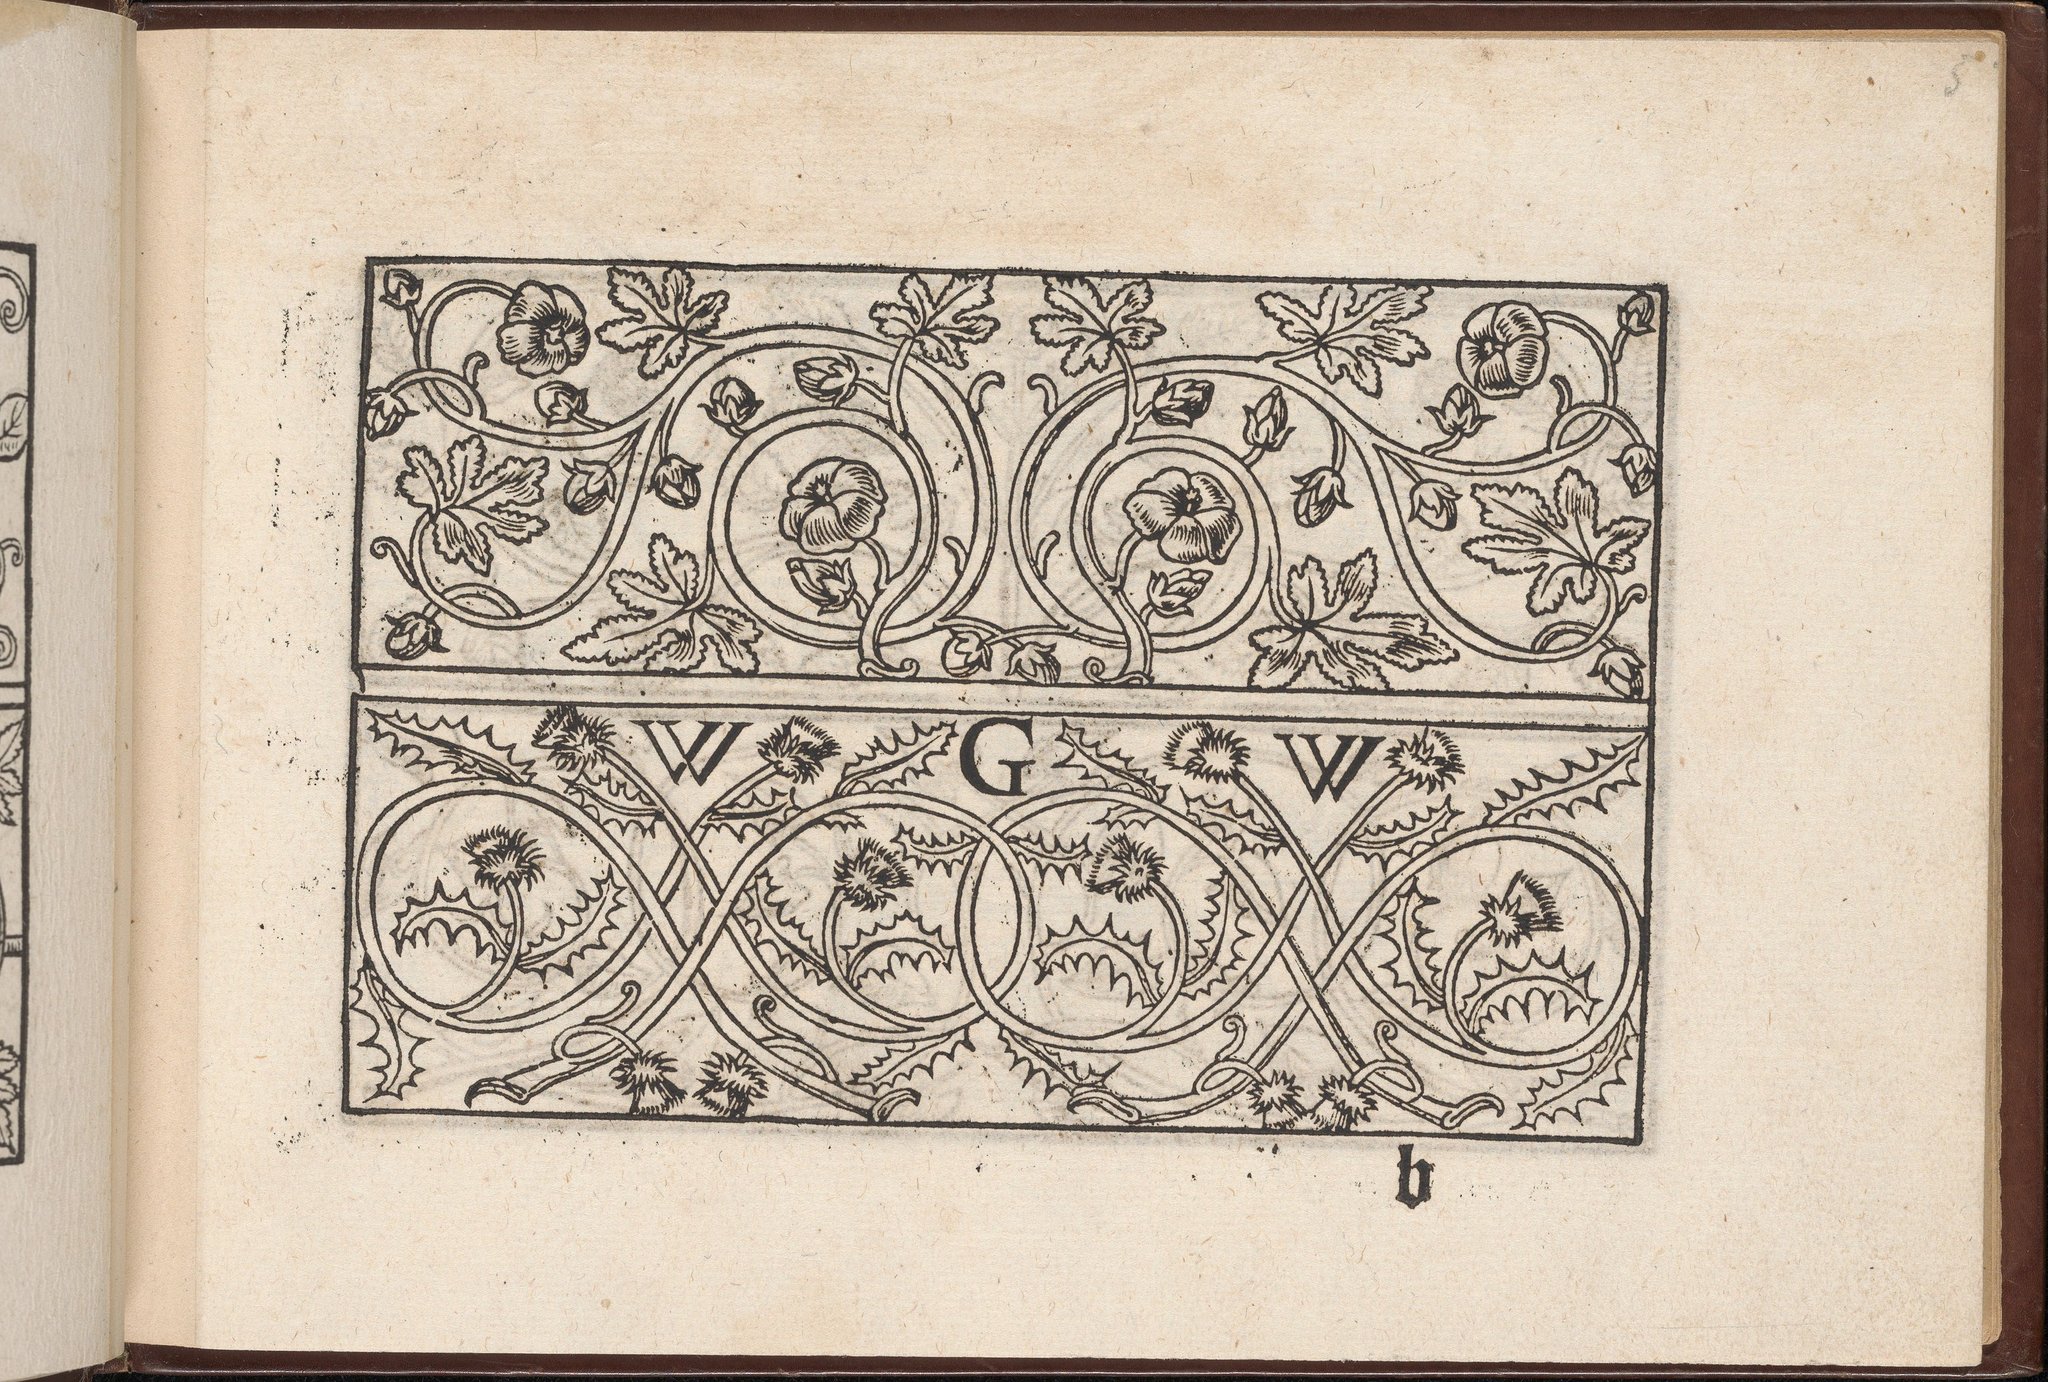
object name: book print ornament architecture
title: Page from Eyn Newe kunstlich moetdelboech alle kunst (Page 5r)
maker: peter quentel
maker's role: publisher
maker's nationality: german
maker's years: 1500-1550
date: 1532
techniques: woodcut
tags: ornament